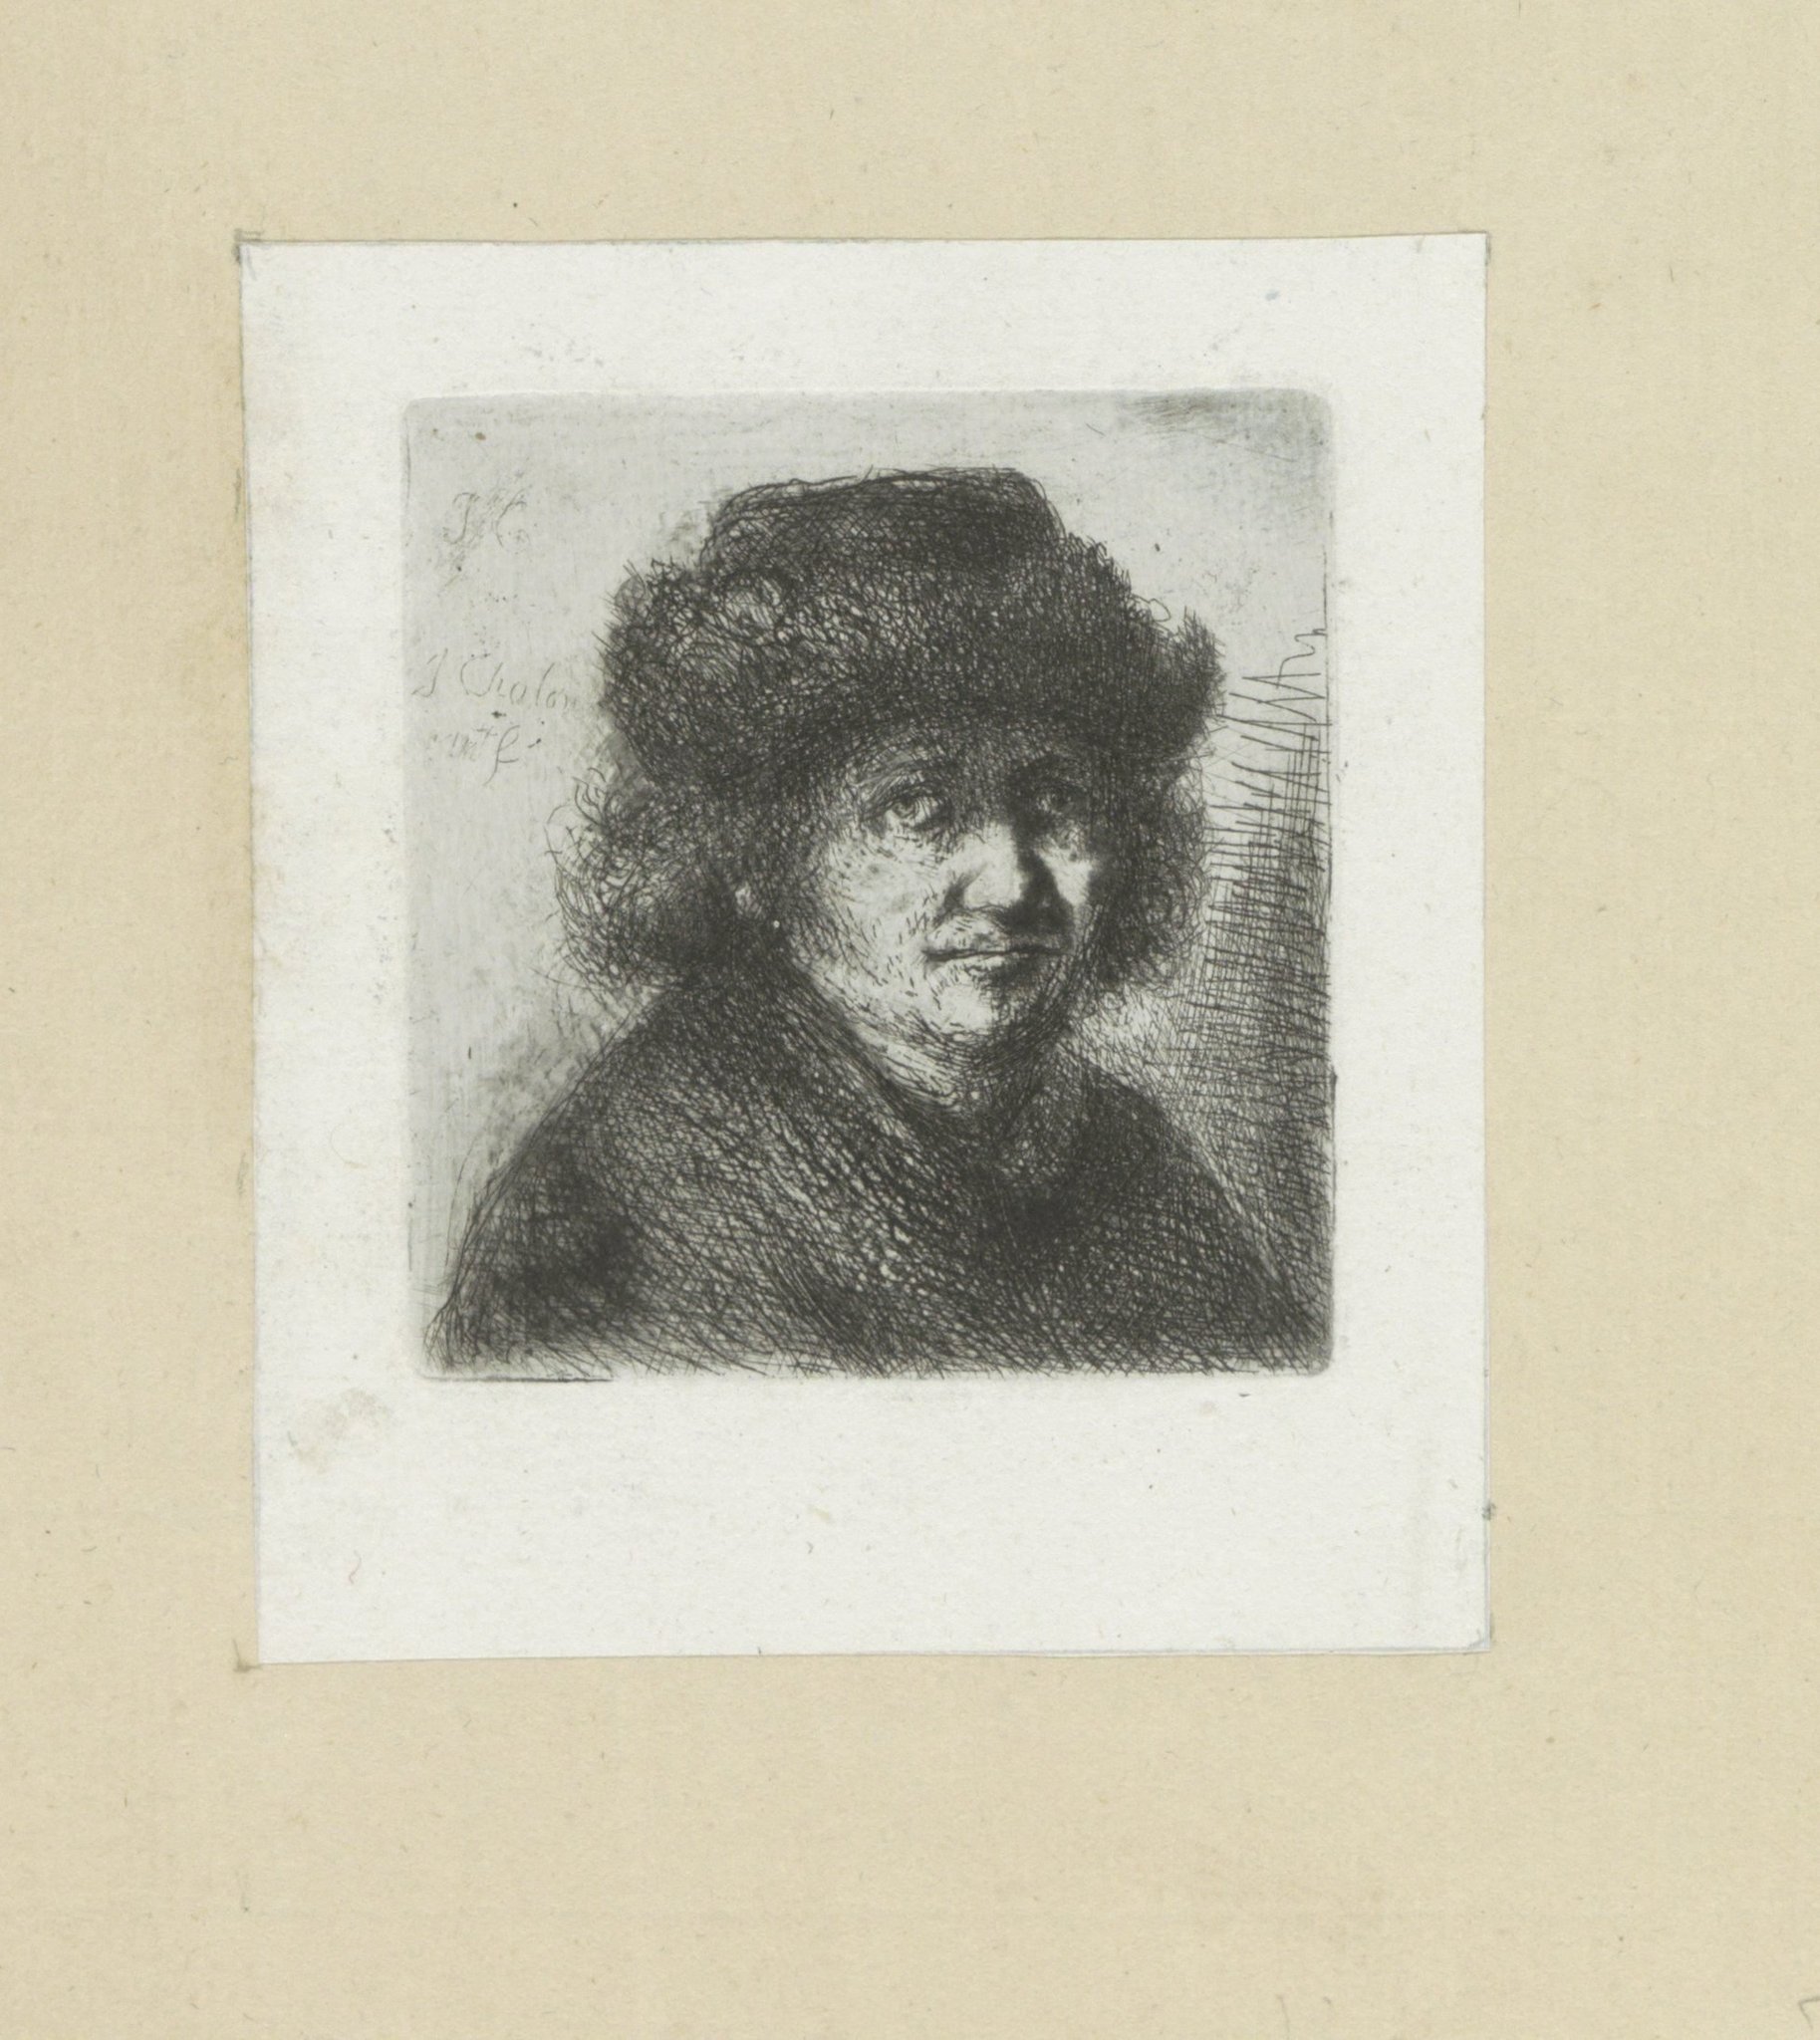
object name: album leaf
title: Volwassen man met hoed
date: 1802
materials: paper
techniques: drypoint, etching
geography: london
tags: head-gear: cap (+ men's clothes), morphology of human expression (+ adult male (human being))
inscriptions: collector's mark: ‘RIJKS / MUSM’, collector's mark: ‘B’